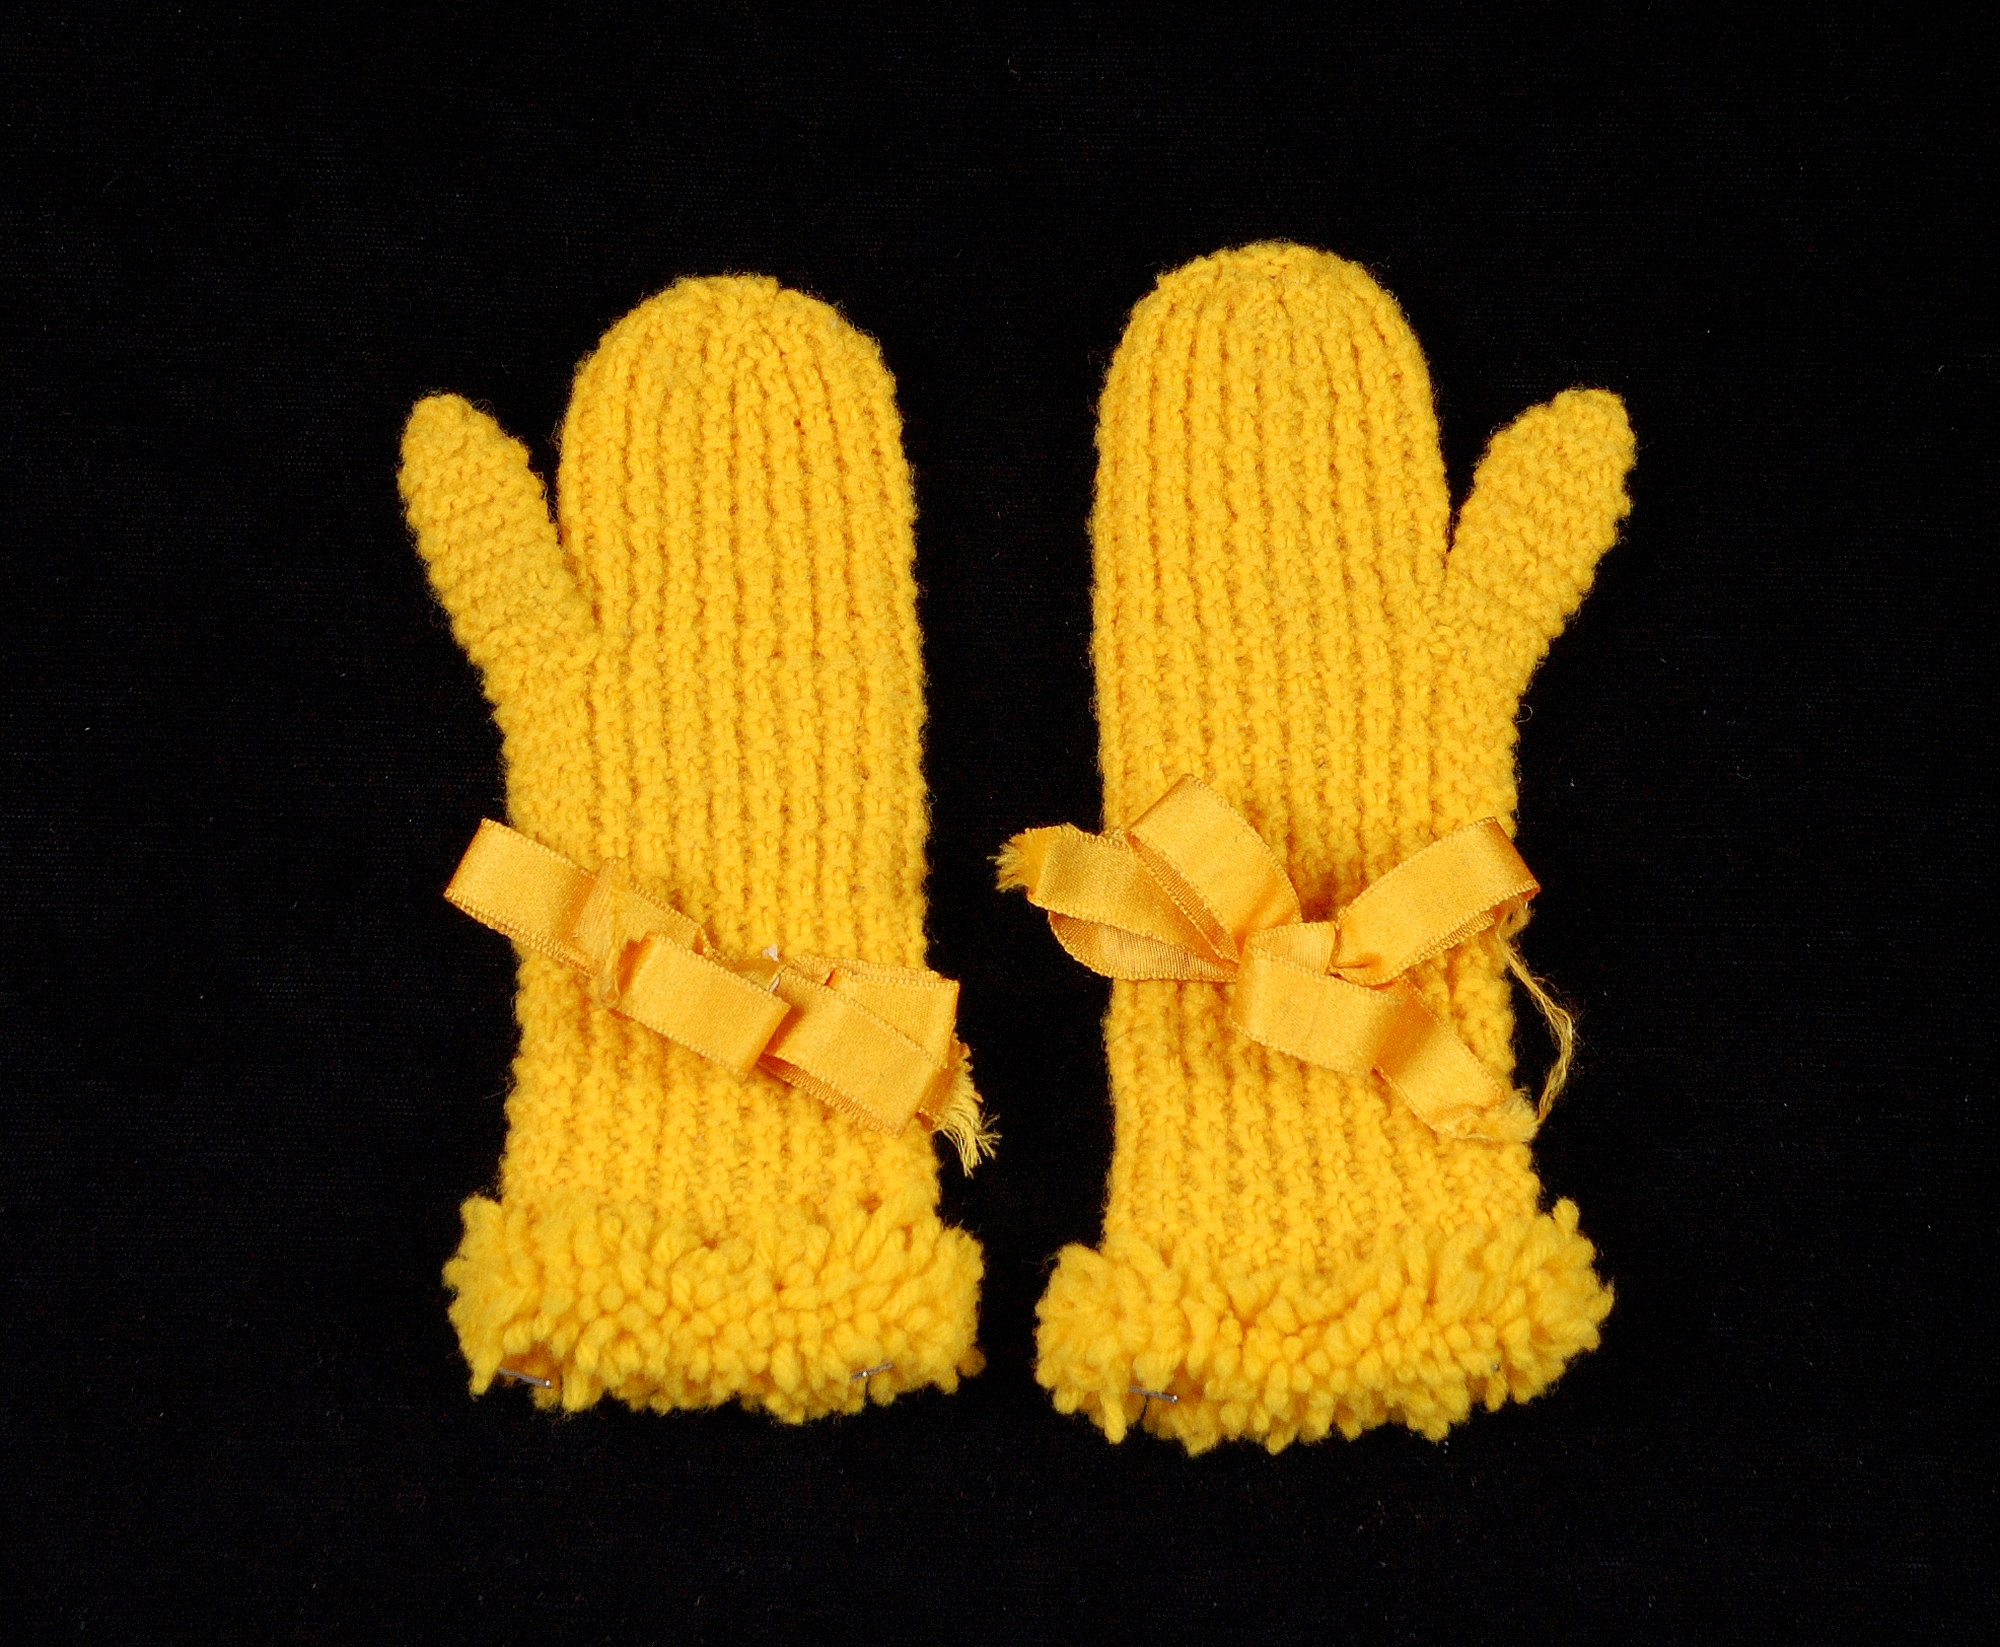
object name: mitten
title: Mittens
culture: american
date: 1880-1889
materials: silk, wool